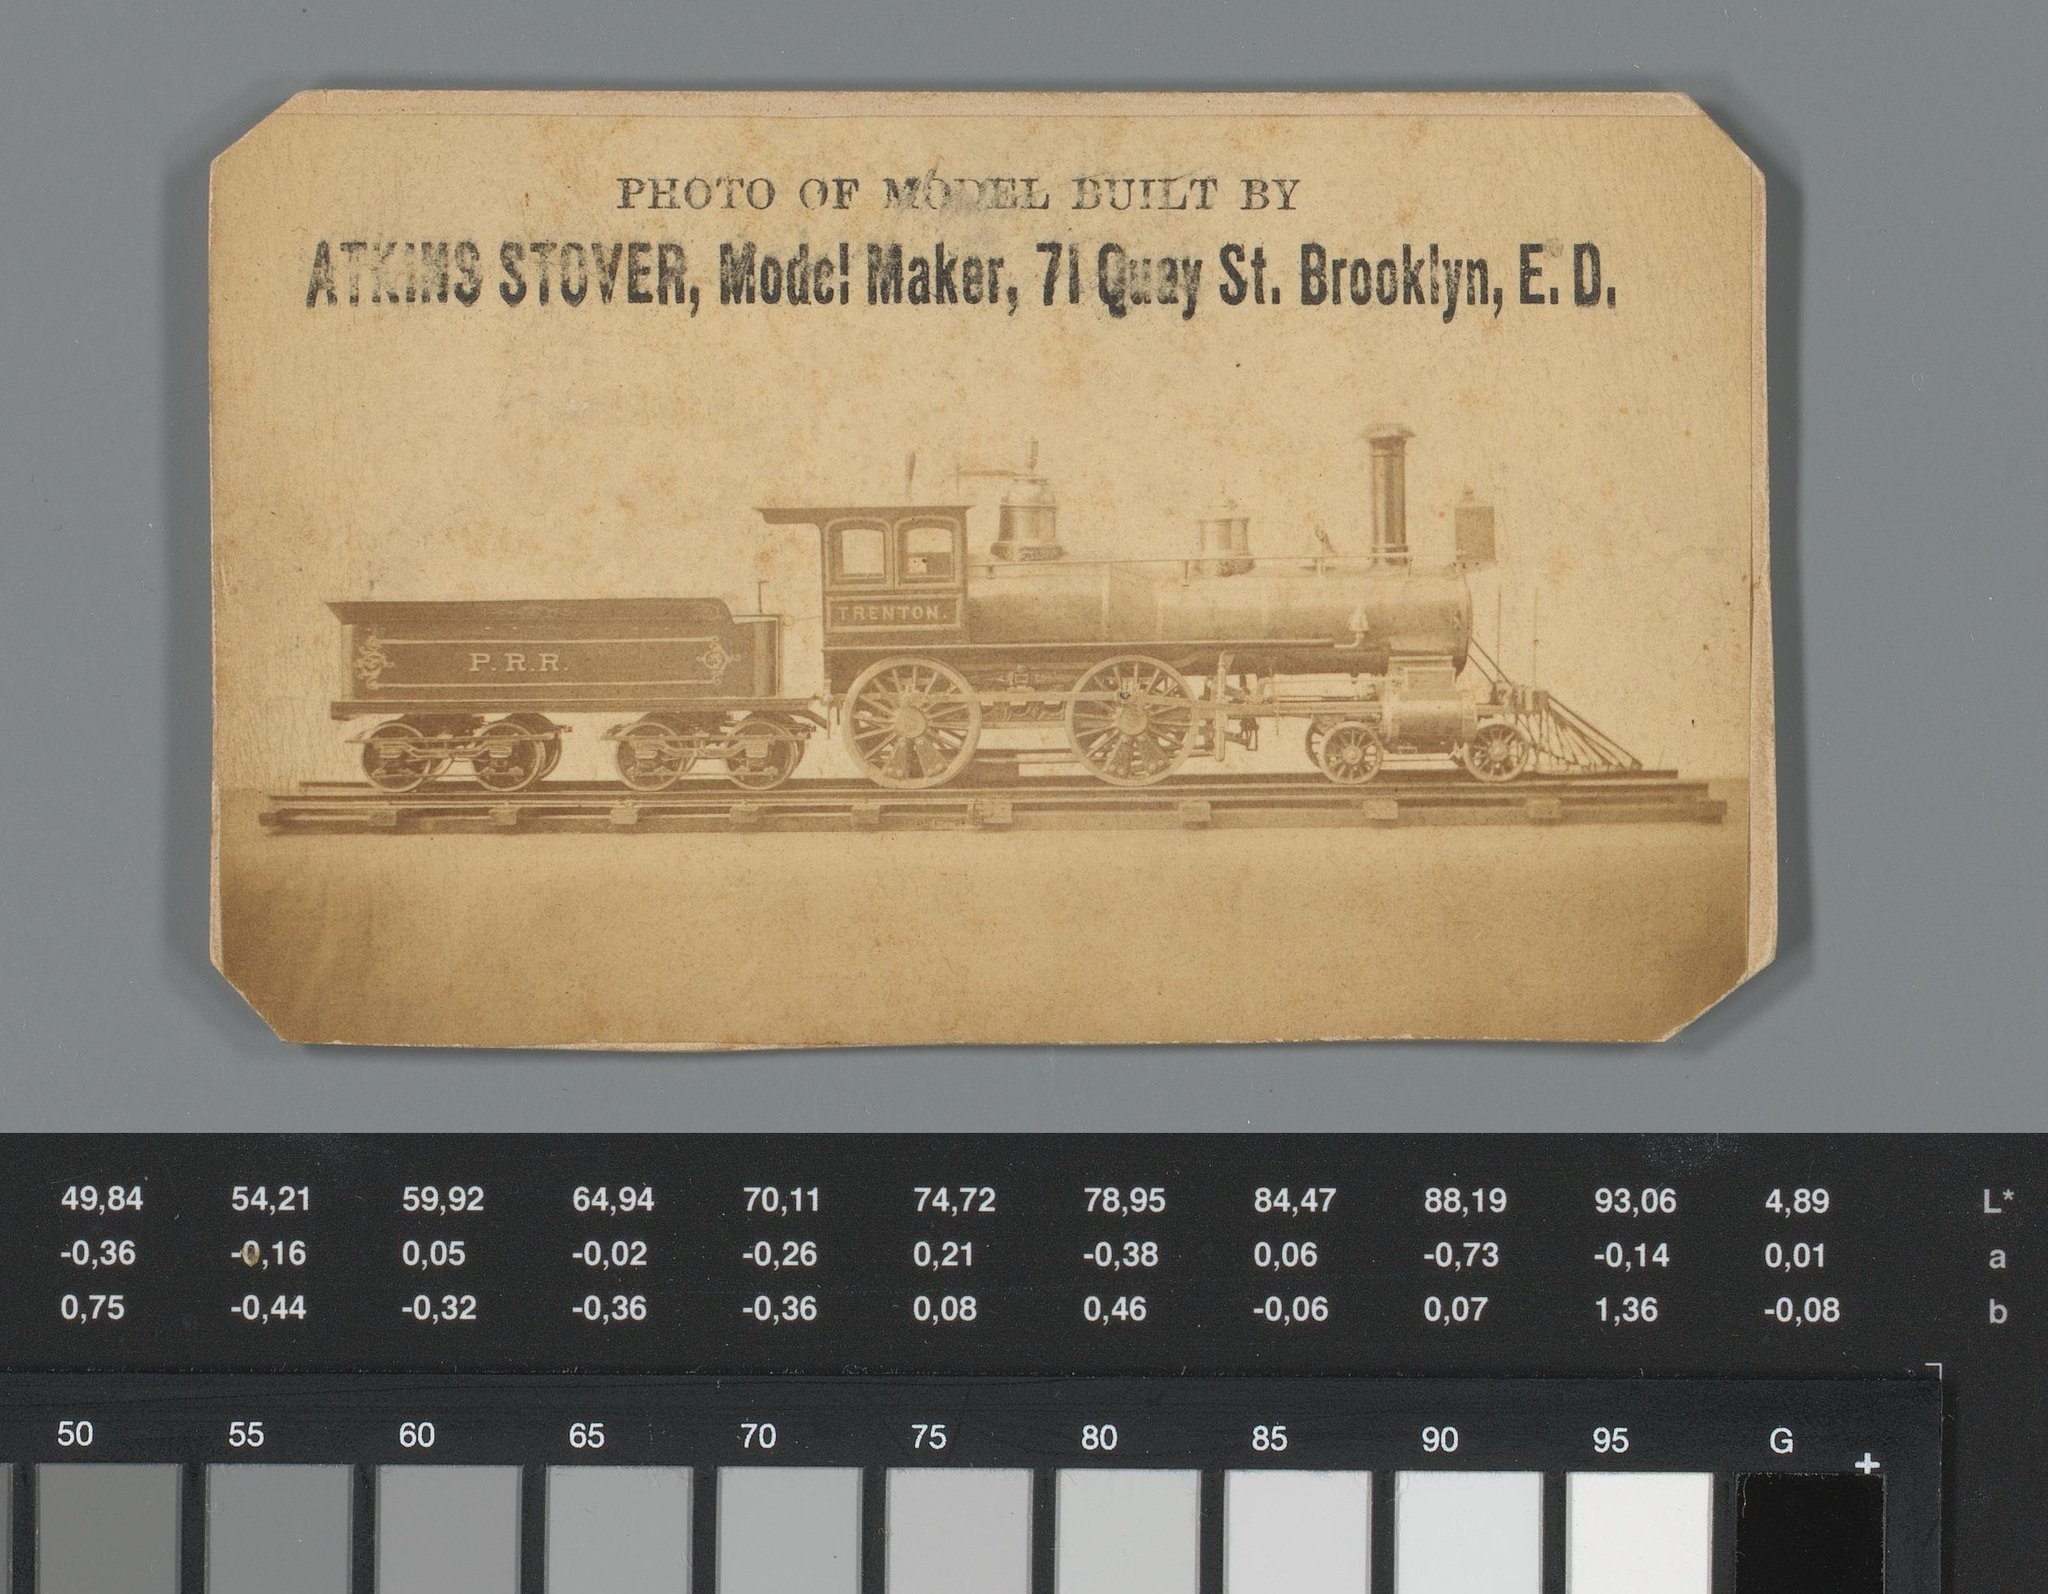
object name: photograph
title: Reclame voor een locomotief van Atkins Stover in Brooklyn, New York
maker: Anonymous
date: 1850-1915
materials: cardboard, photographic support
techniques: albumen print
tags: advertising, steam locomotive